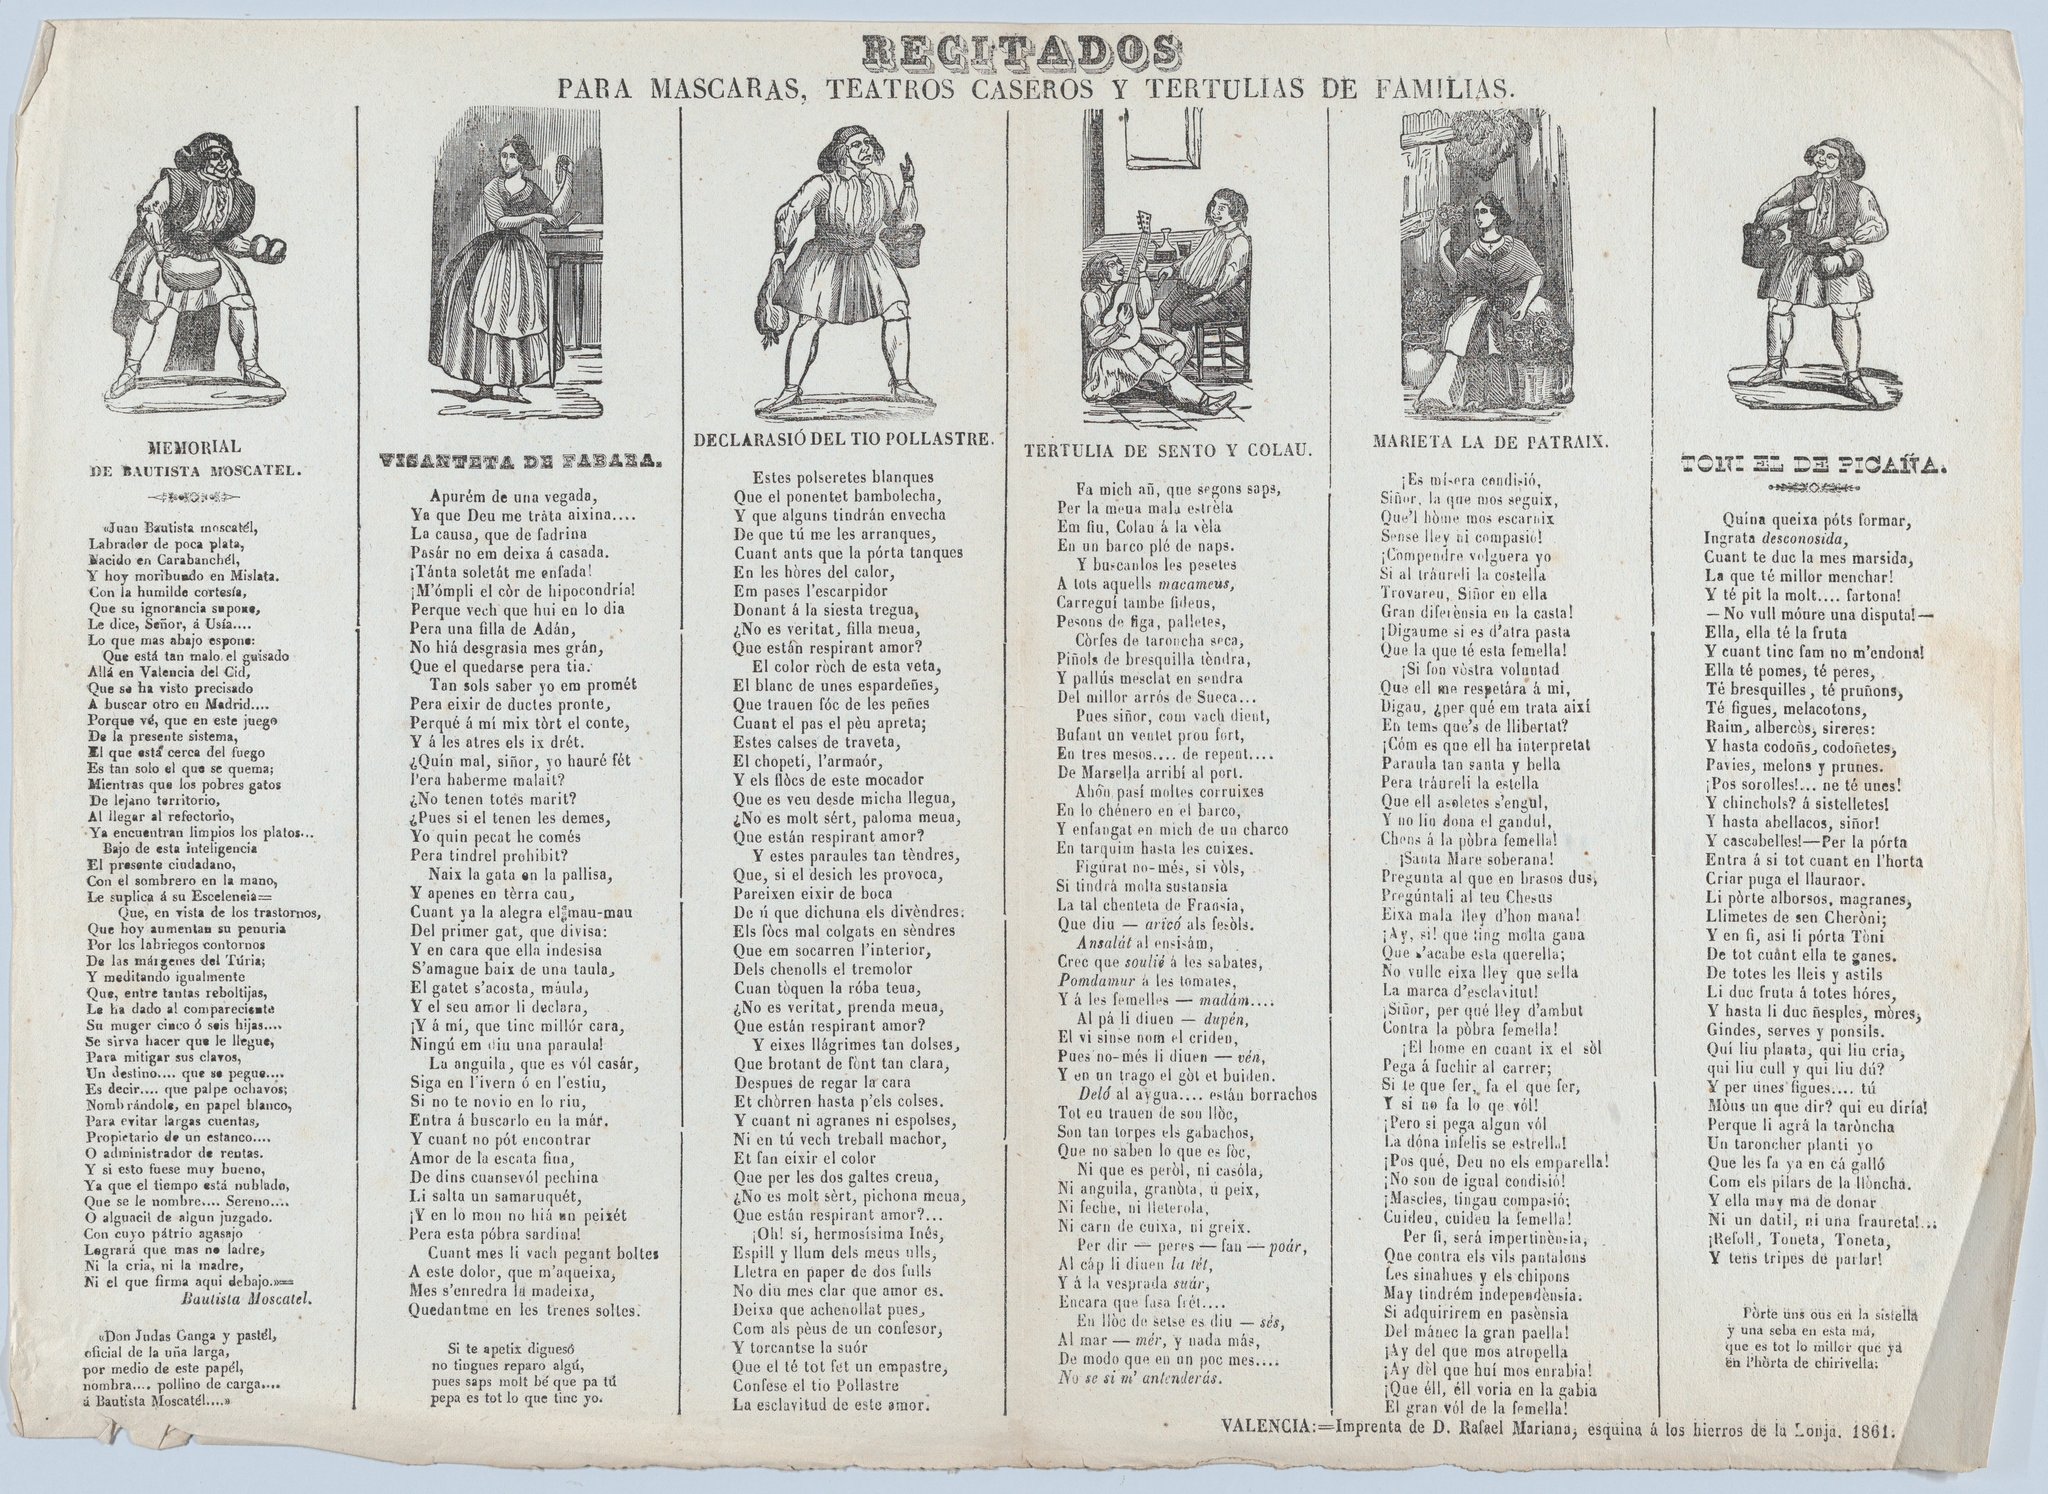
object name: print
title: A recital sheet featuring different characters for use at social gatherings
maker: rafael mariana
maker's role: publisher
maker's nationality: spanish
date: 1861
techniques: letterpress, engraving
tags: musical instruments,men,women